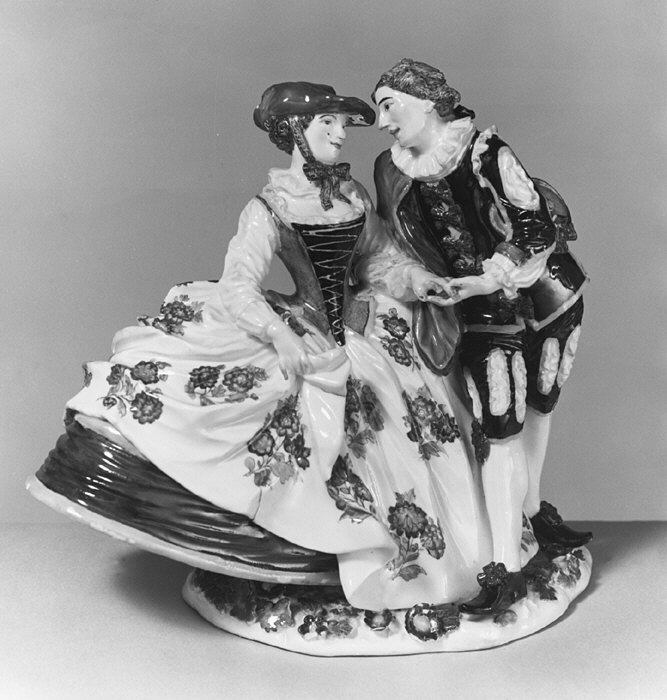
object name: group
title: Beltrame and Columbine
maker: meissen manufactory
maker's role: manufactory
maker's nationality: german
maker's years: 1710-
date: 1741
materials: hard paste porcelain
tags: men,lovers,women